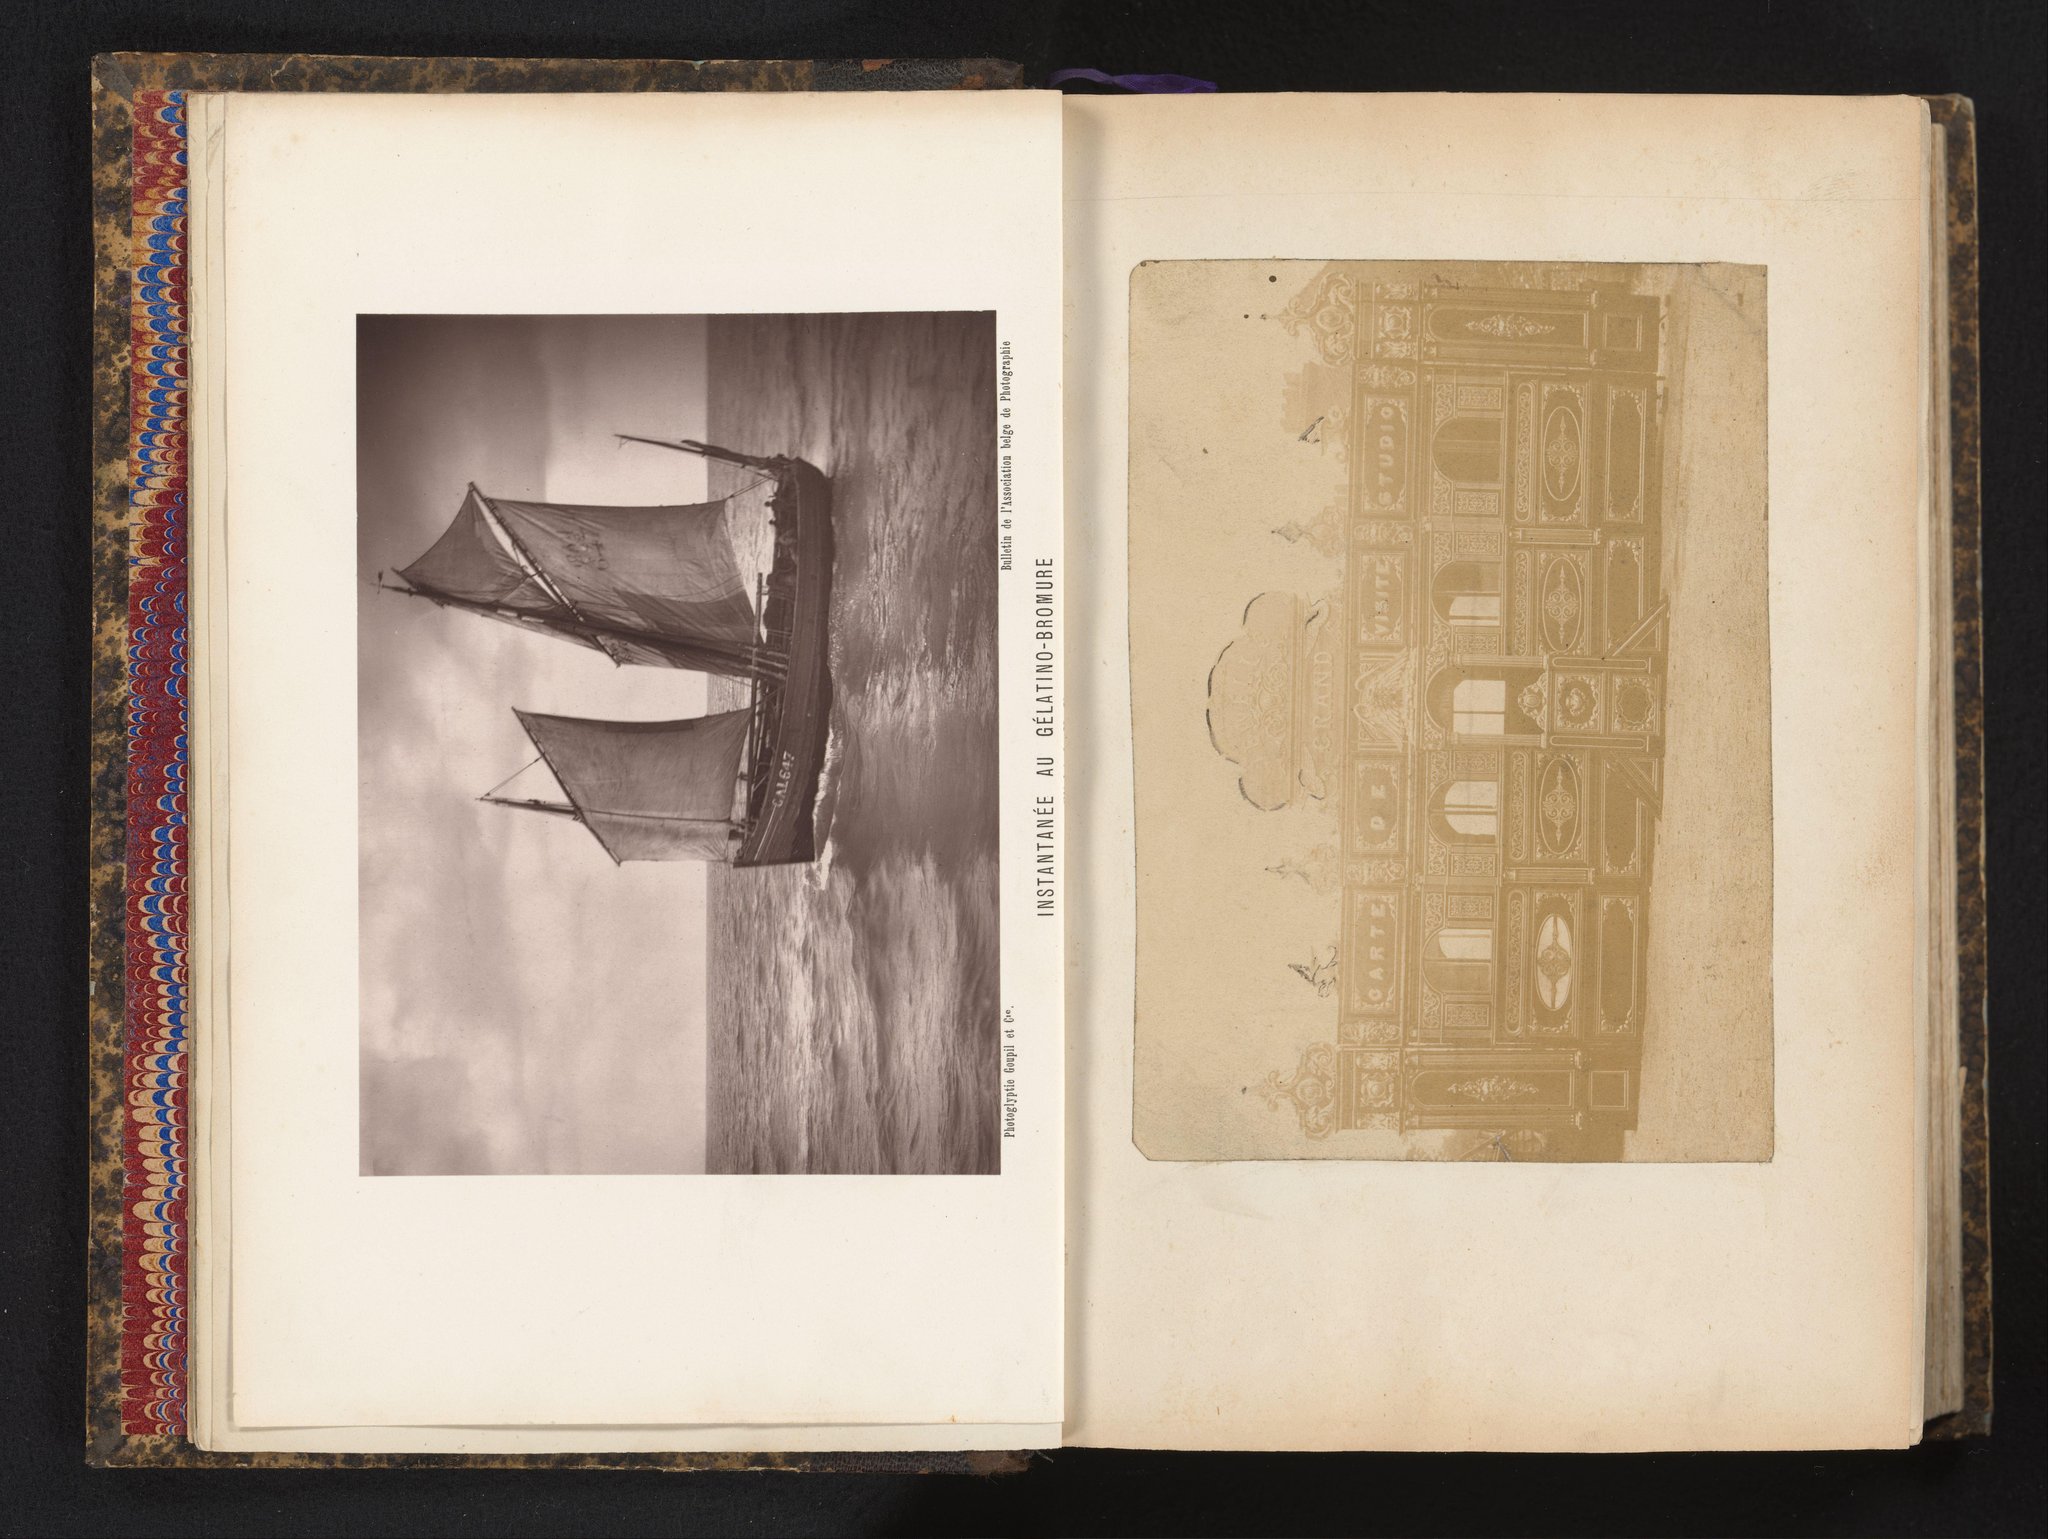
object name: page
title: Gezicht op een zeilboot te water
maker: Anonymous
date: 1878-1882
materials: paper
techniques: woodburytype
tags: sailing-ship, sailing-boat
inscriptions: inscription: ‘Instantanée au Gélatino-bromure’, inscription: ‘Cliché de M. Neyt.’, inscription: ‘Bulletin de l'Association belge de Photographie’